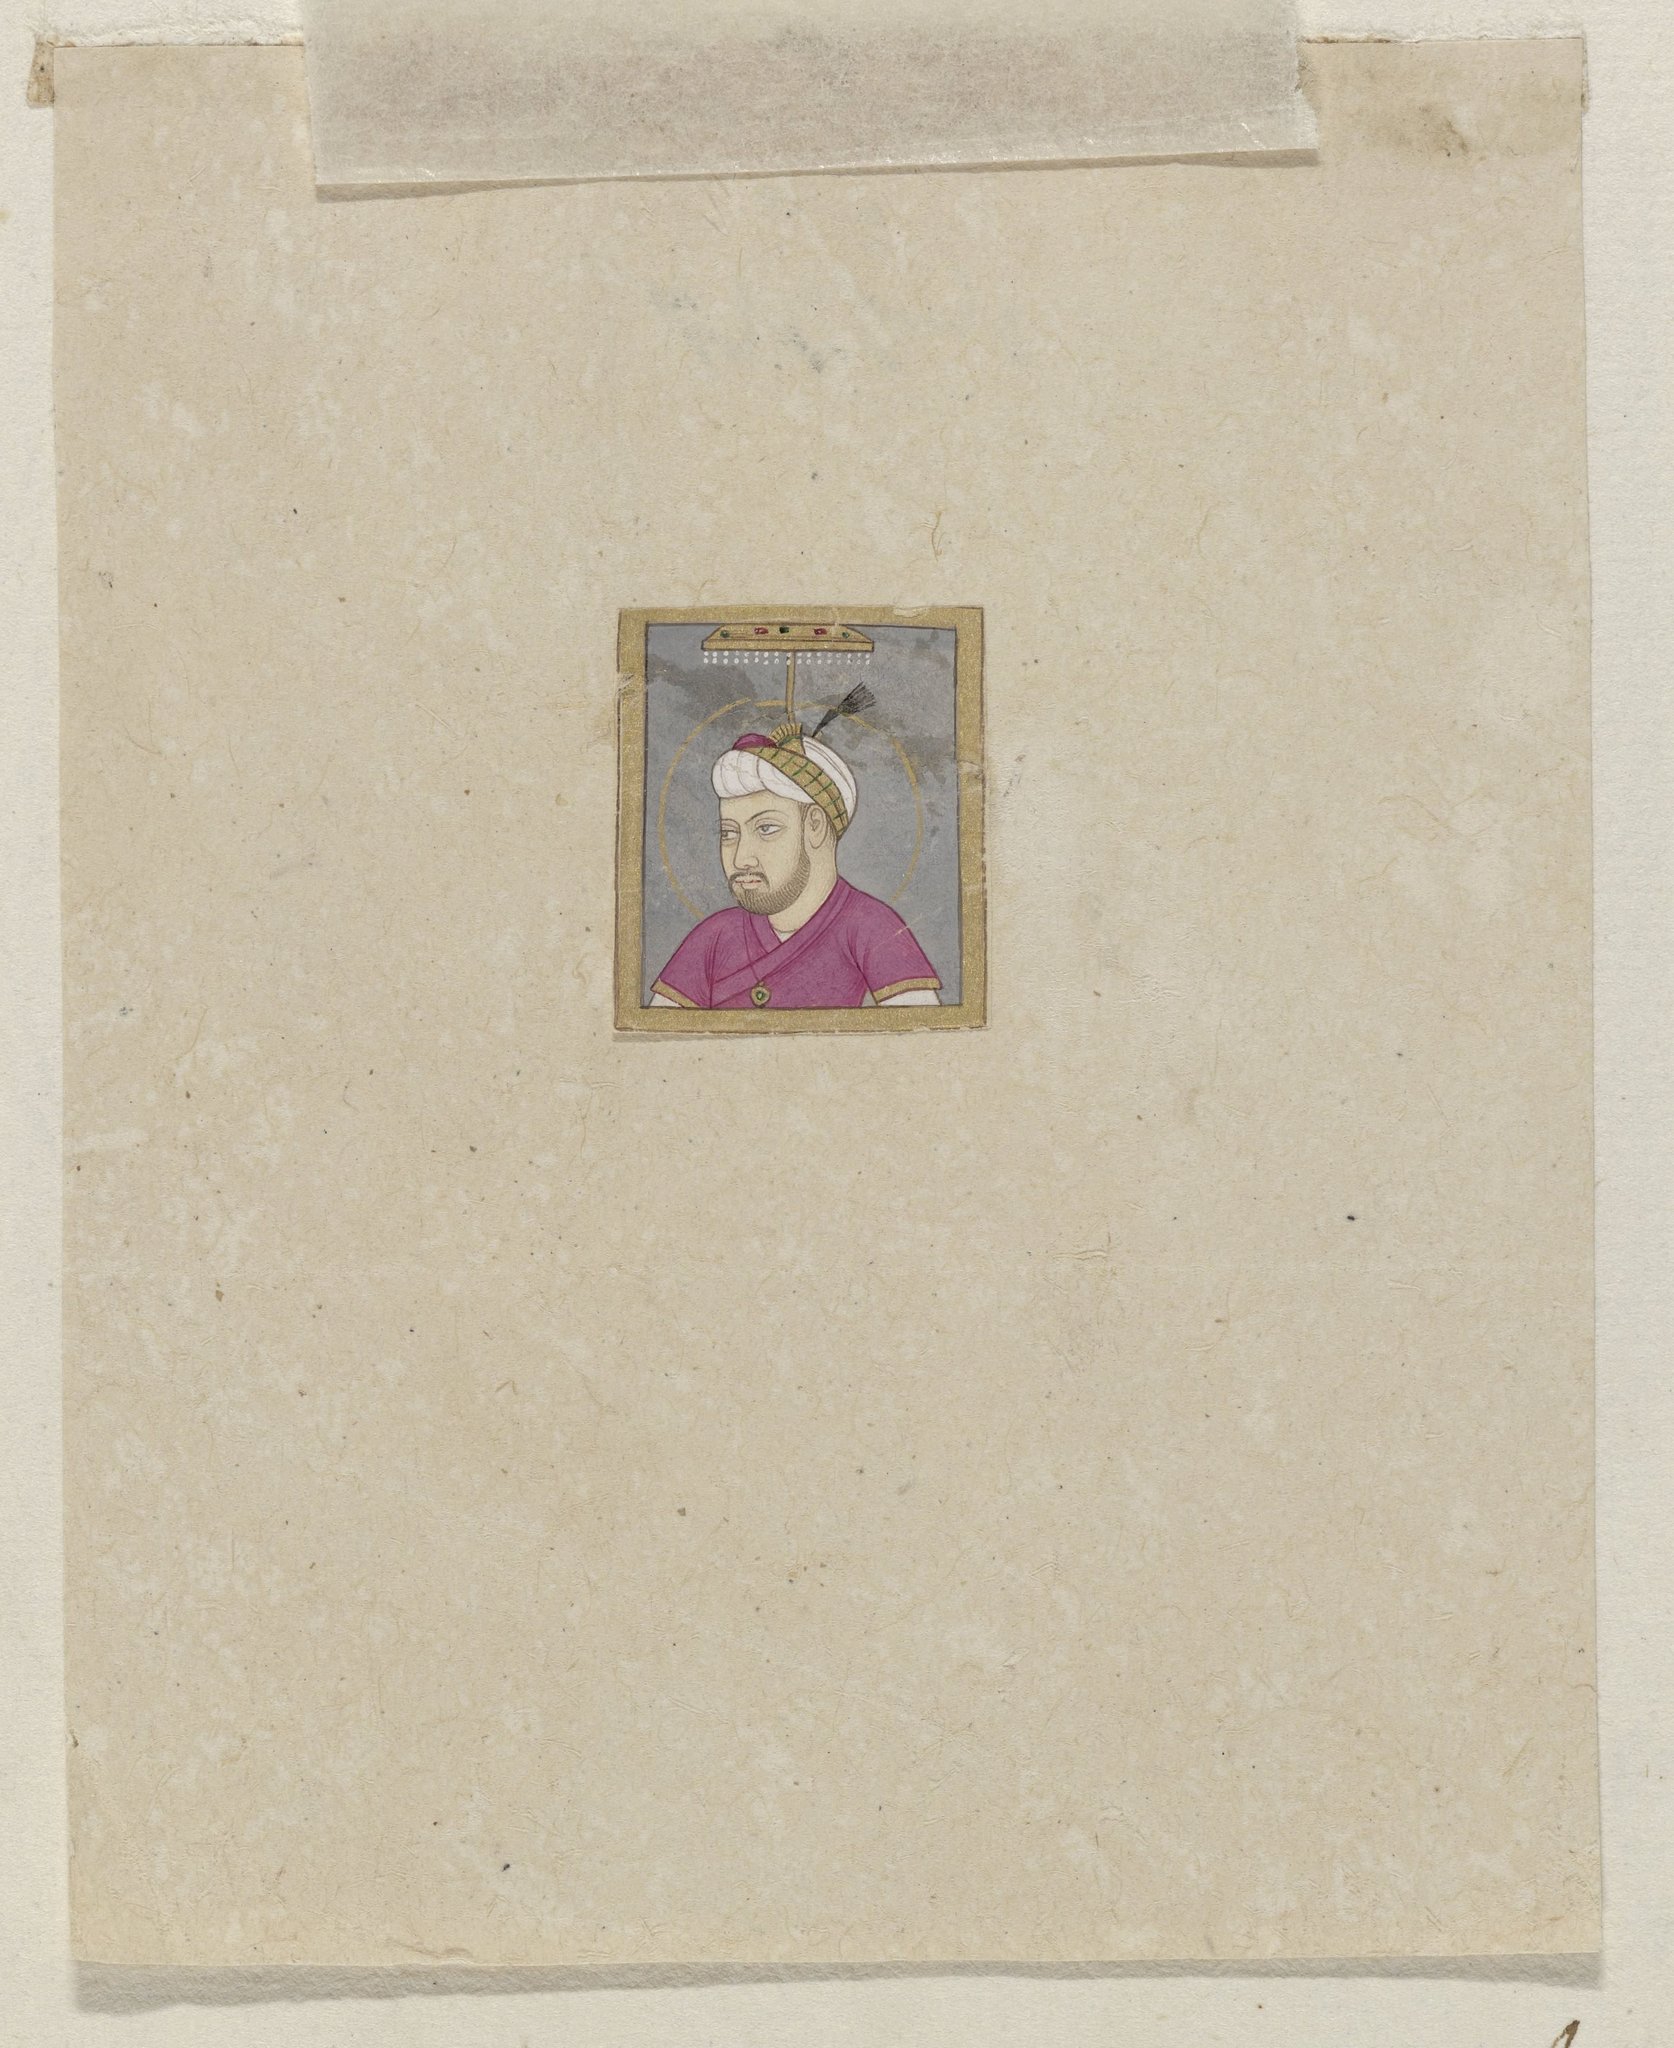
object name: drawing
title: Modsoedin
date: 1675-1725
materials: paper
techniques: drawing, writing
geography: deccan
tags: adrianus canter visscher, historical persons, ruler, sovereign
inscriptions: caption: ‘Modsoedin oudste soon van Baduncha dertiende koning / of mogol van Indostan, na nauwelijks een jaar de troon / beklommen te hebben werd hij door sijn broeders soon Azem tanna / in name fanochen overwonnen ontroond, en onthoofd.’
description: Tekening uit het manuscript van de VOC dienaar Adrianus Canter Visscher met achterin achtentwintig Indiase miniaturen en twee kaarten van plaatsen aan de Coromandelkust. De tekst bestaat uit twee delen: een geschiedenis van het Mogolrijk en de VOC-vestigingen aan de Coromandelkust; daarna volgt een advies aan de Heren XVII over de economische situatie van de VOC in de Coromandel.